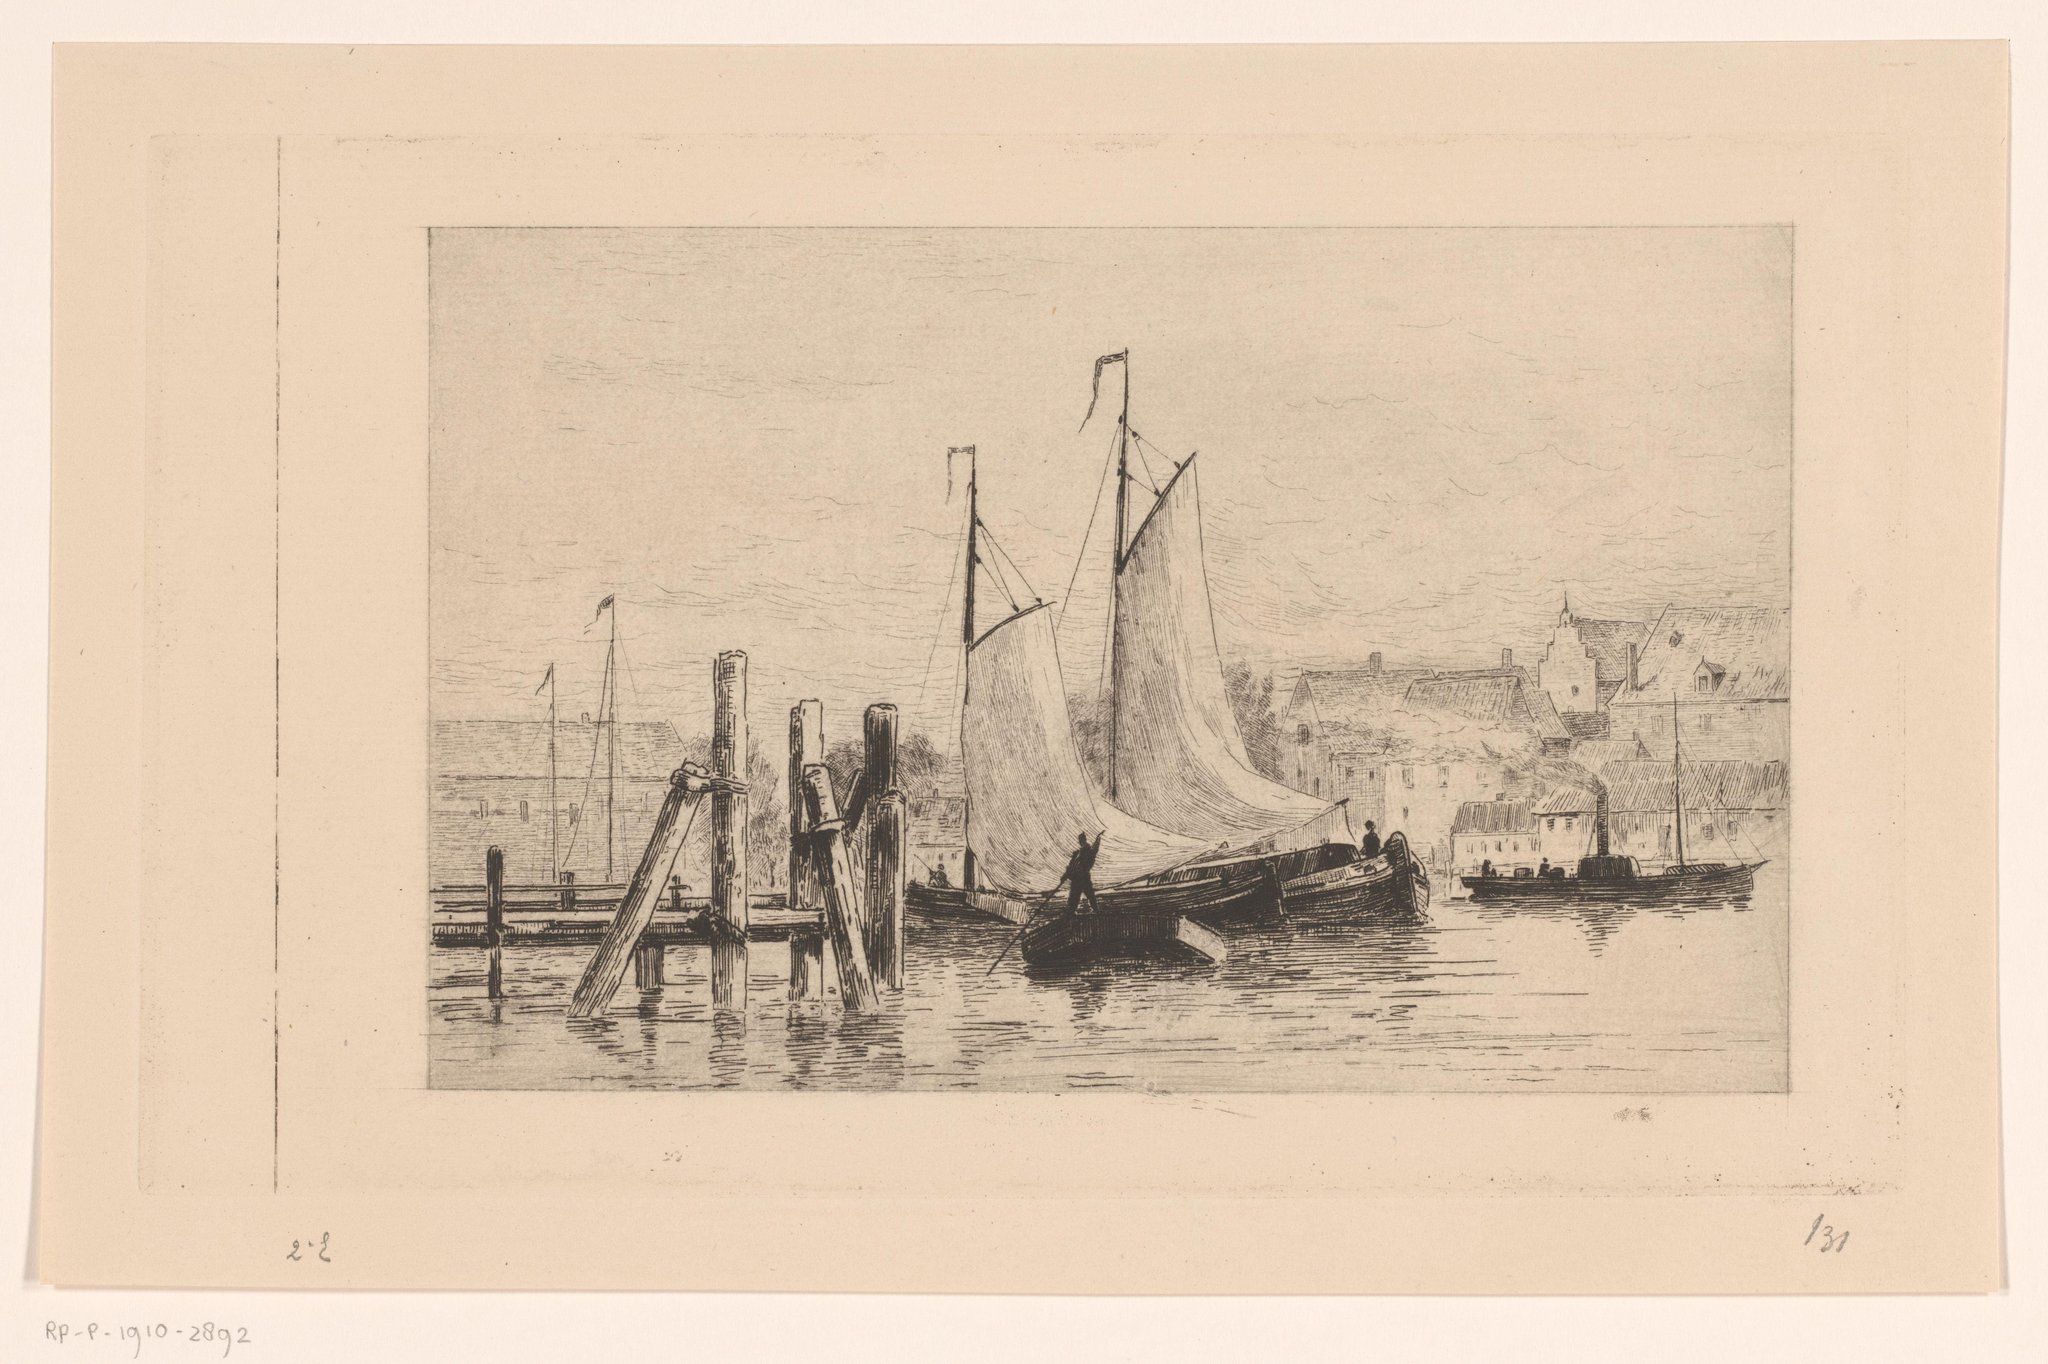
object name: print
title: Dans le port de Dordrecht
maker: carel nicolaas storm van s-gravesande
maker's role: draughtsman, print maker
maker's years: 1841-1924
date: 1880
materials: paper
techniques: etching, intaglio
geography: netherlands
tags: harbour, dordrecht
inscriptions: collector's mark: Lugt 2228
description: Links een steiger; in het midden zeilboten.